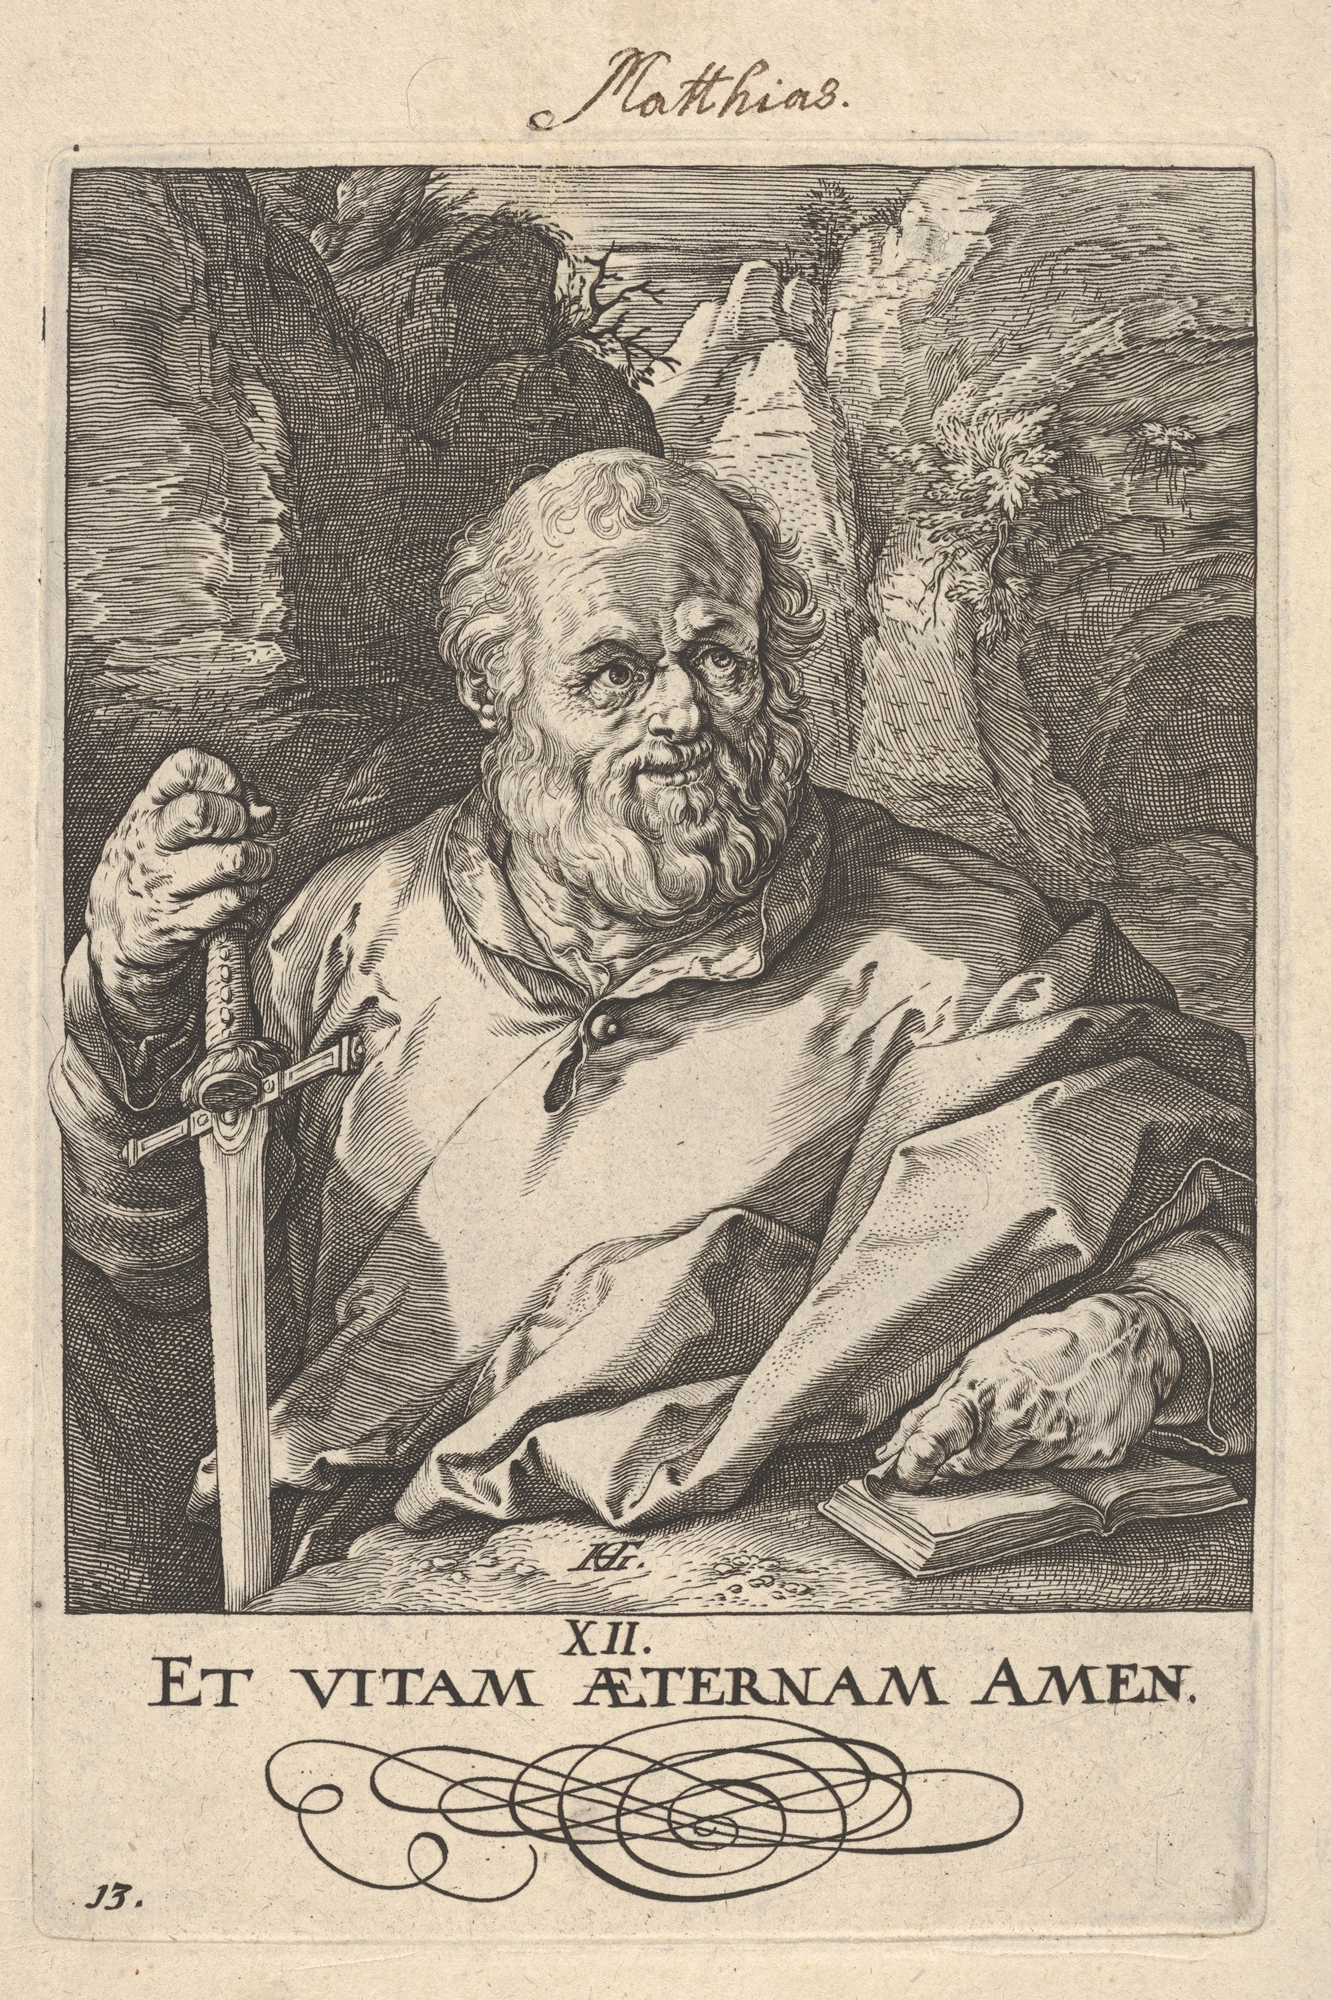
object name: print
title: St. Matthias, from "Christ, the Apostles and St. Paul with the Creed"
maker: hendrick goltzius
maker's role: artist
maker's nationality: netherlandish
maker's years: 1558-1617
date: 1589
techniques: engraving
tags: swords,apostles,saints